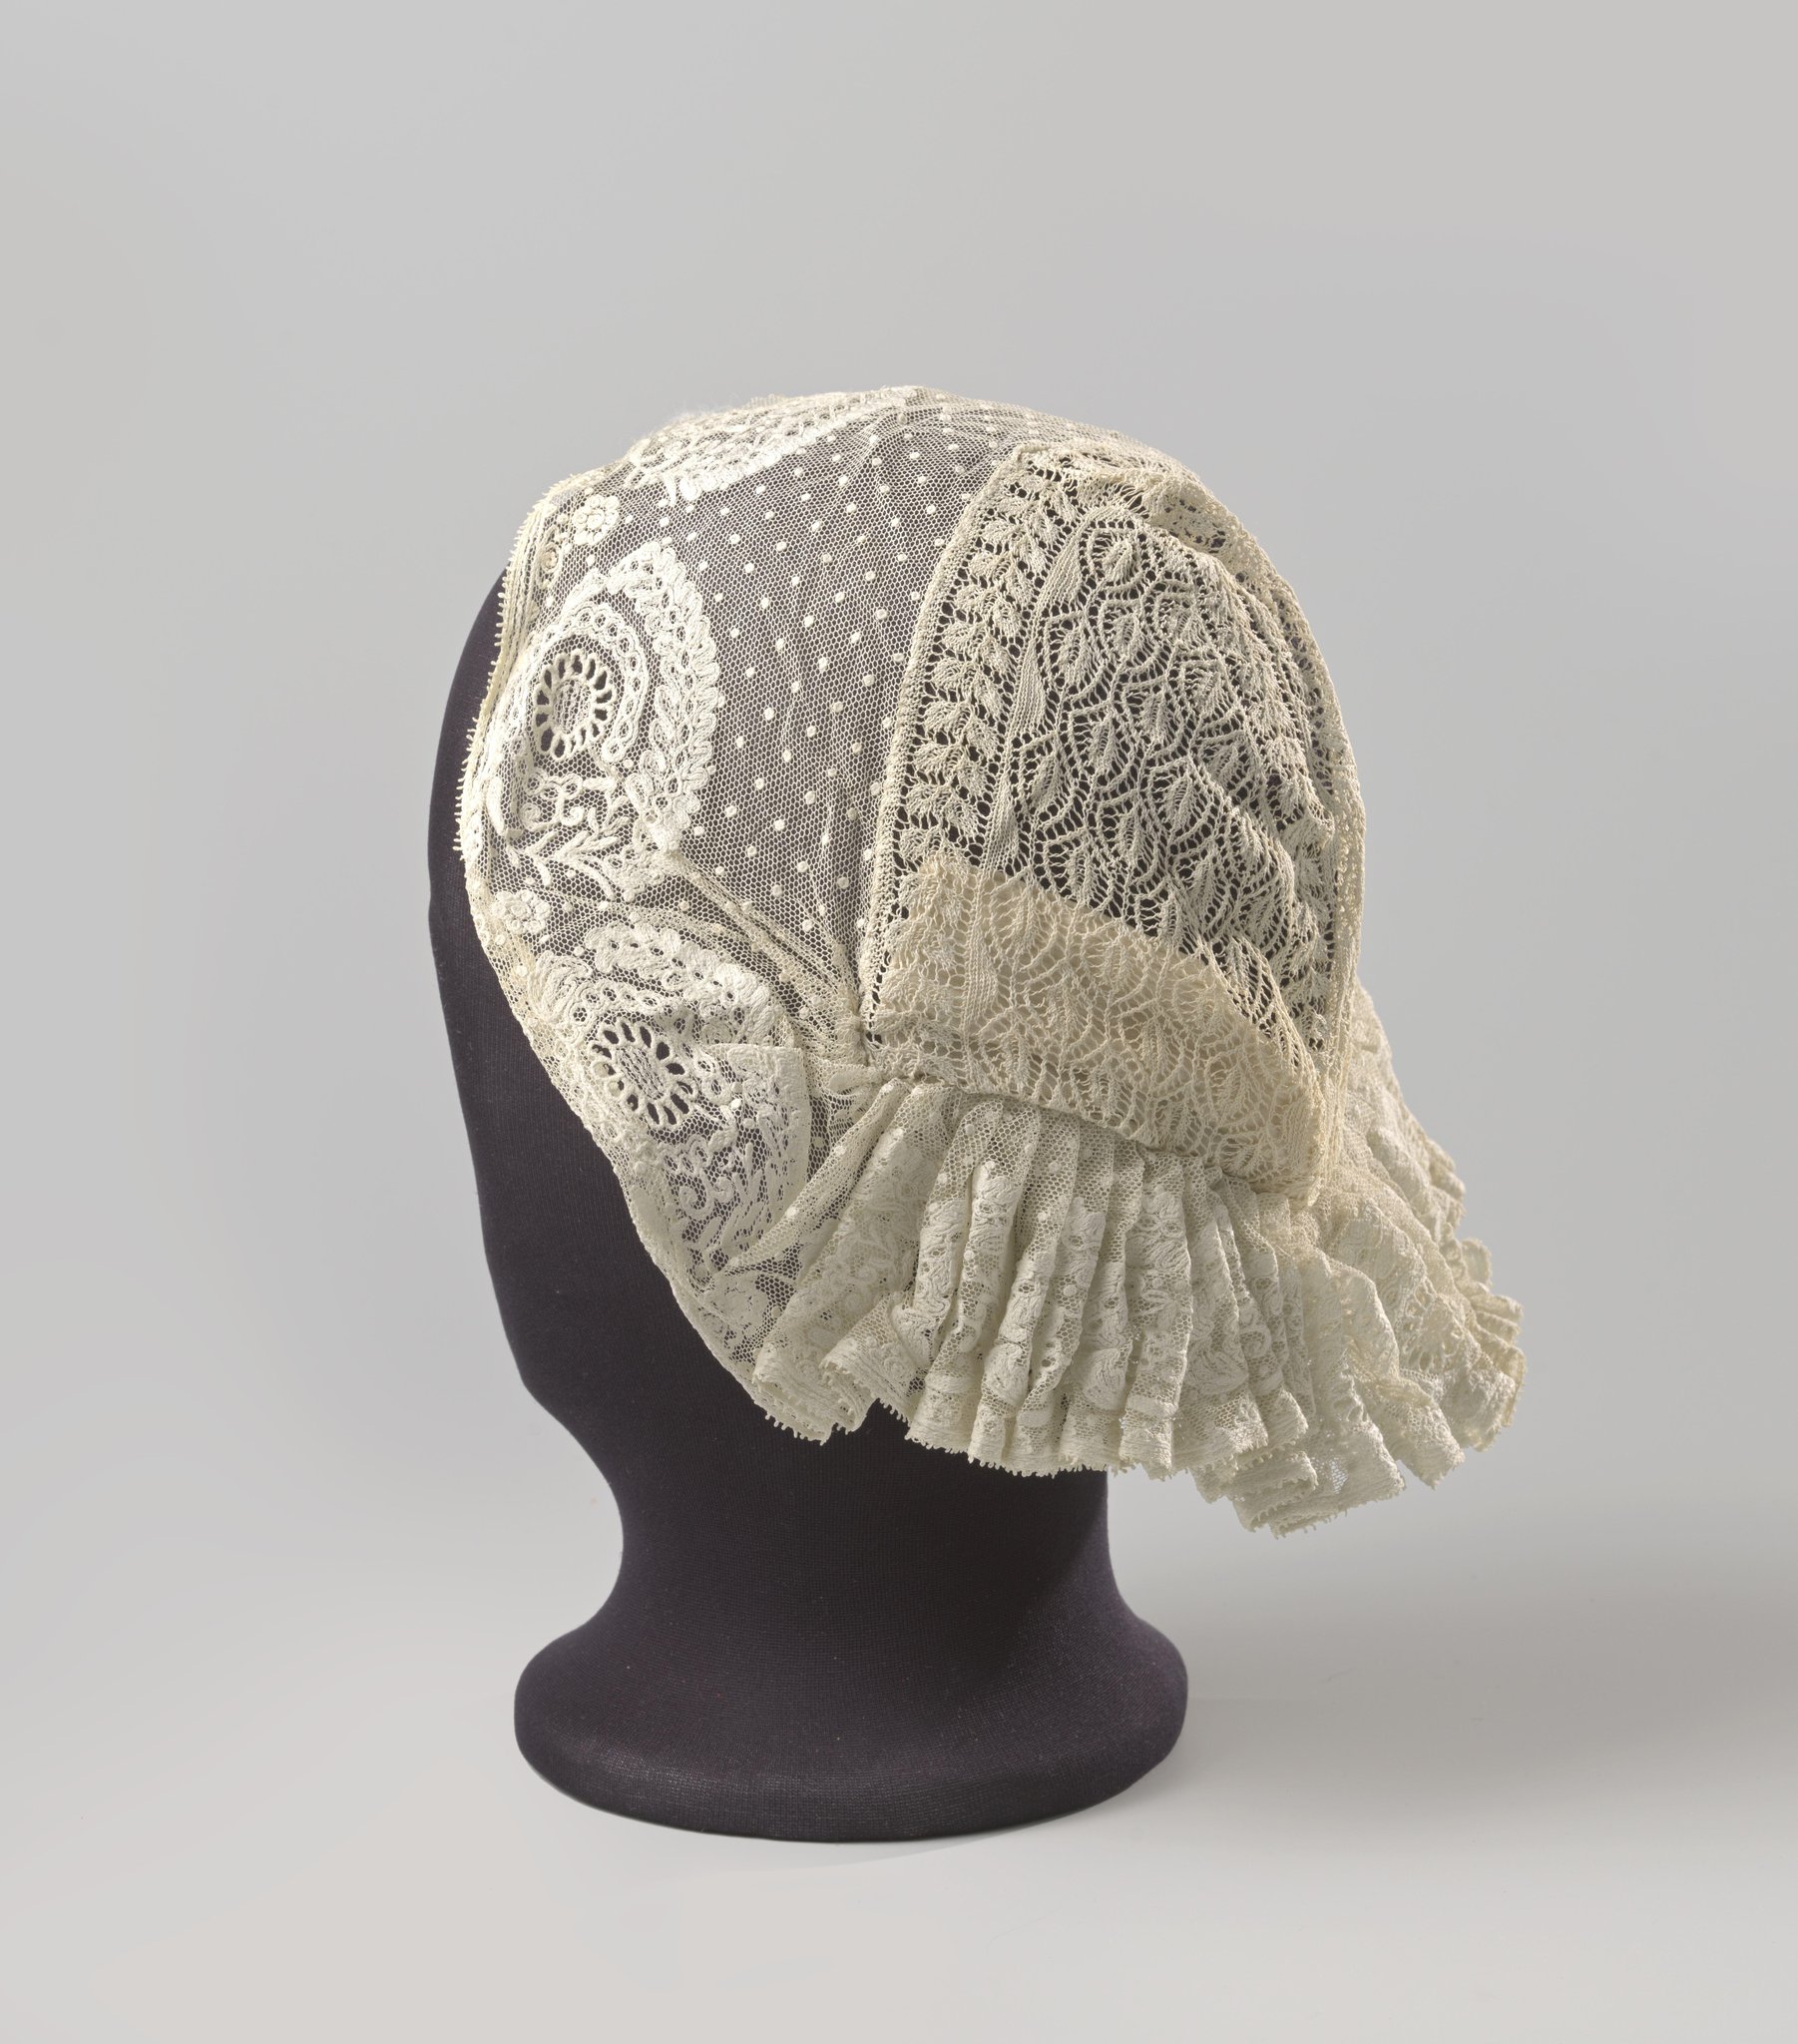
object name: streekdracht, streekkleding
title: Muts met bol van Friese kant in fijn breiwerk, afgezet met een strook tule versierd met tamboereerwerk (Lierse kant) dat langs het voorhoofd geplooid is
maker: Anonymous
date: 1800-1900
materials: linen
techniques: material, knitting, weave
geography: friesland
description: Muts met bol van Friese kant in fijn breiwerk, afgezet met een strook tule versierd met tamboereerwerk (Lierse kant). Langs het voorhoofd is de tule geplooid.